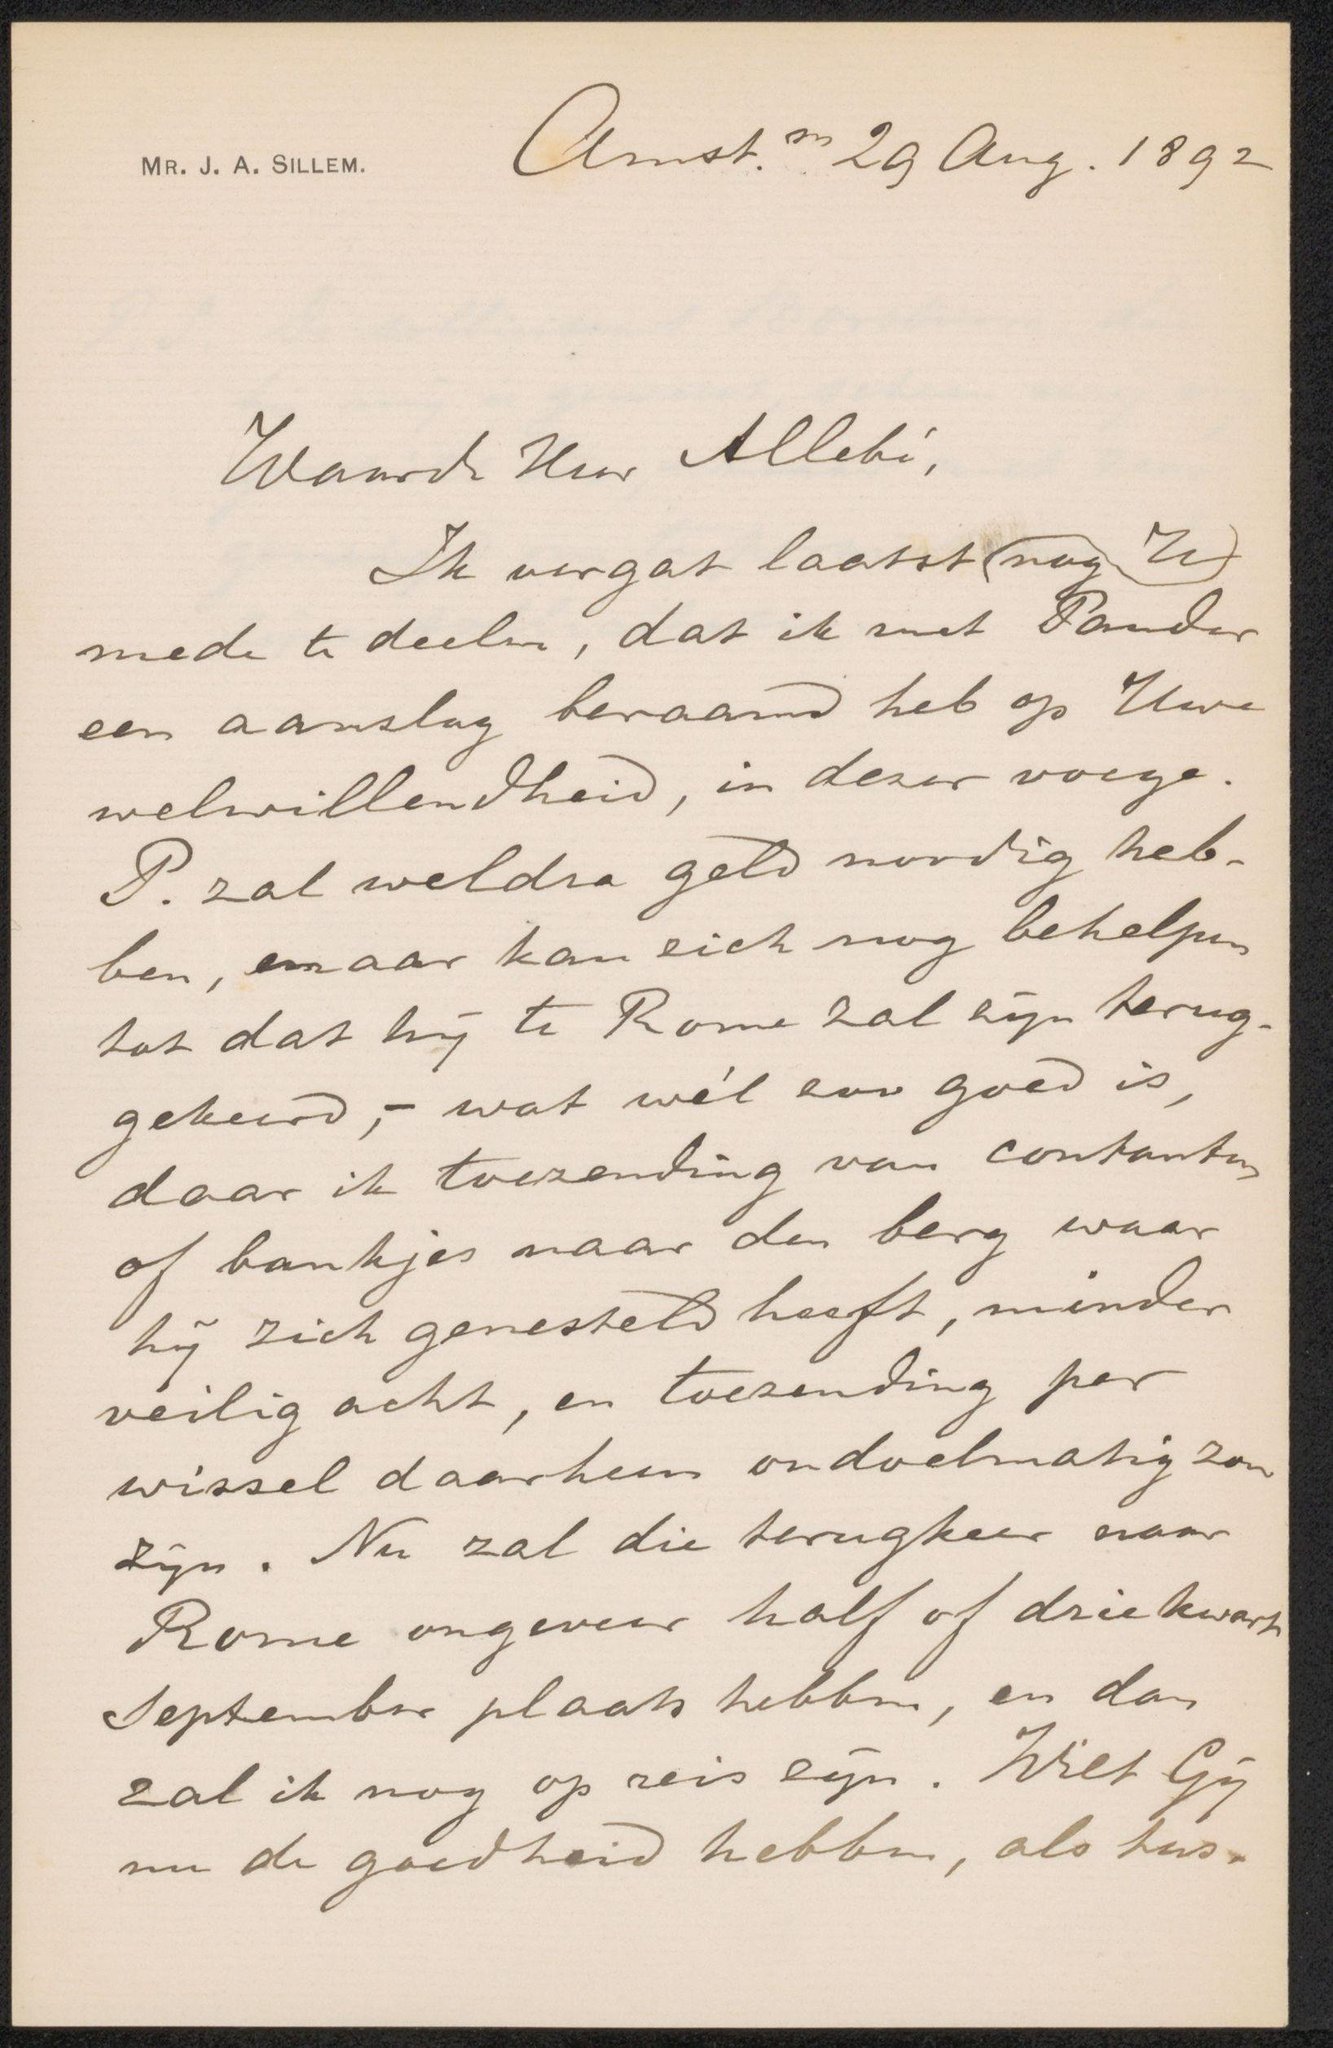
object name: letter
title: Brief aan August Allebé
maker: jérôme alexander sillem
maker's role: politician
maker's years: 1840-1912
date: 1892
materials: ink, paper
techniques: pen, printing, writing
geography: amsterdam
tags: print maker, draughtsman, august allebé, rome, designer, sculptor, pier pander, travelling; tourism, money